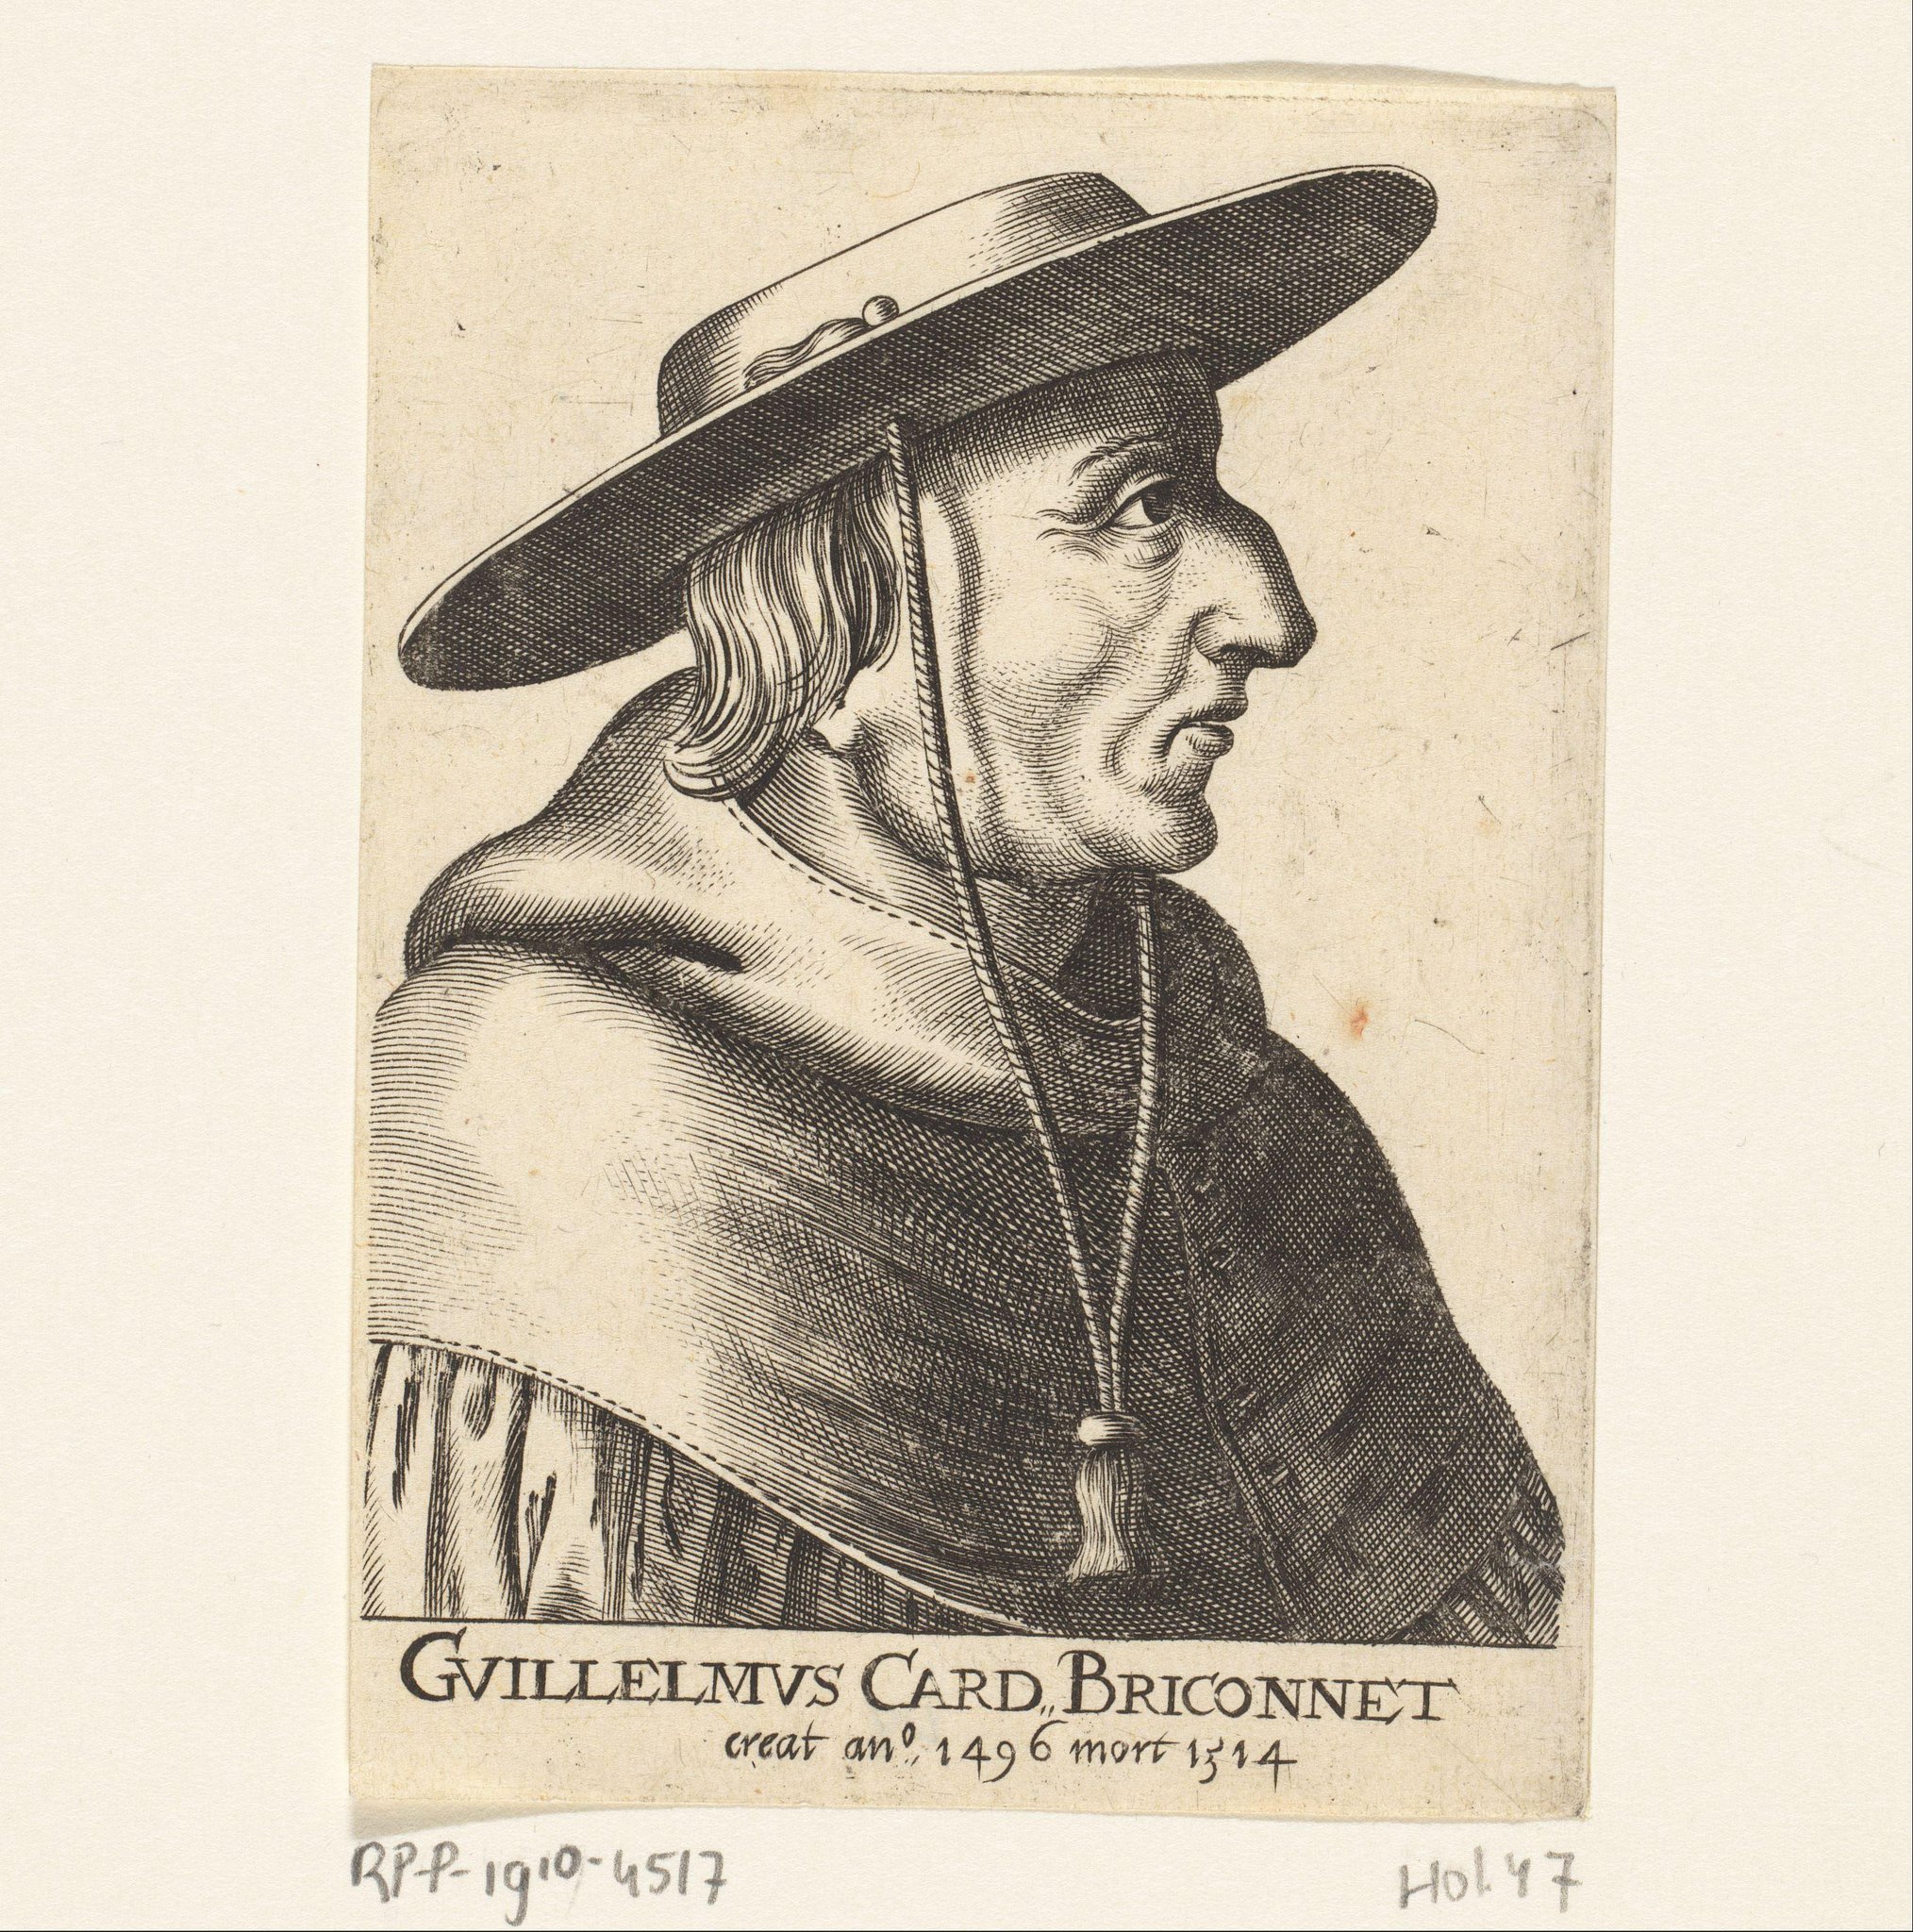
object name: print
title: Portret van de Franse kardinaal Guillaume Briçonnet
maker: frans van den wijngaerde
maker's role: print maker, publisher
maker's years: 1614-1679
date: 1636-1679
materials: paper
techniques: engraving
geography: antwerp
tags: cardinal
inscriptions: collector's mark: Lugt 2228